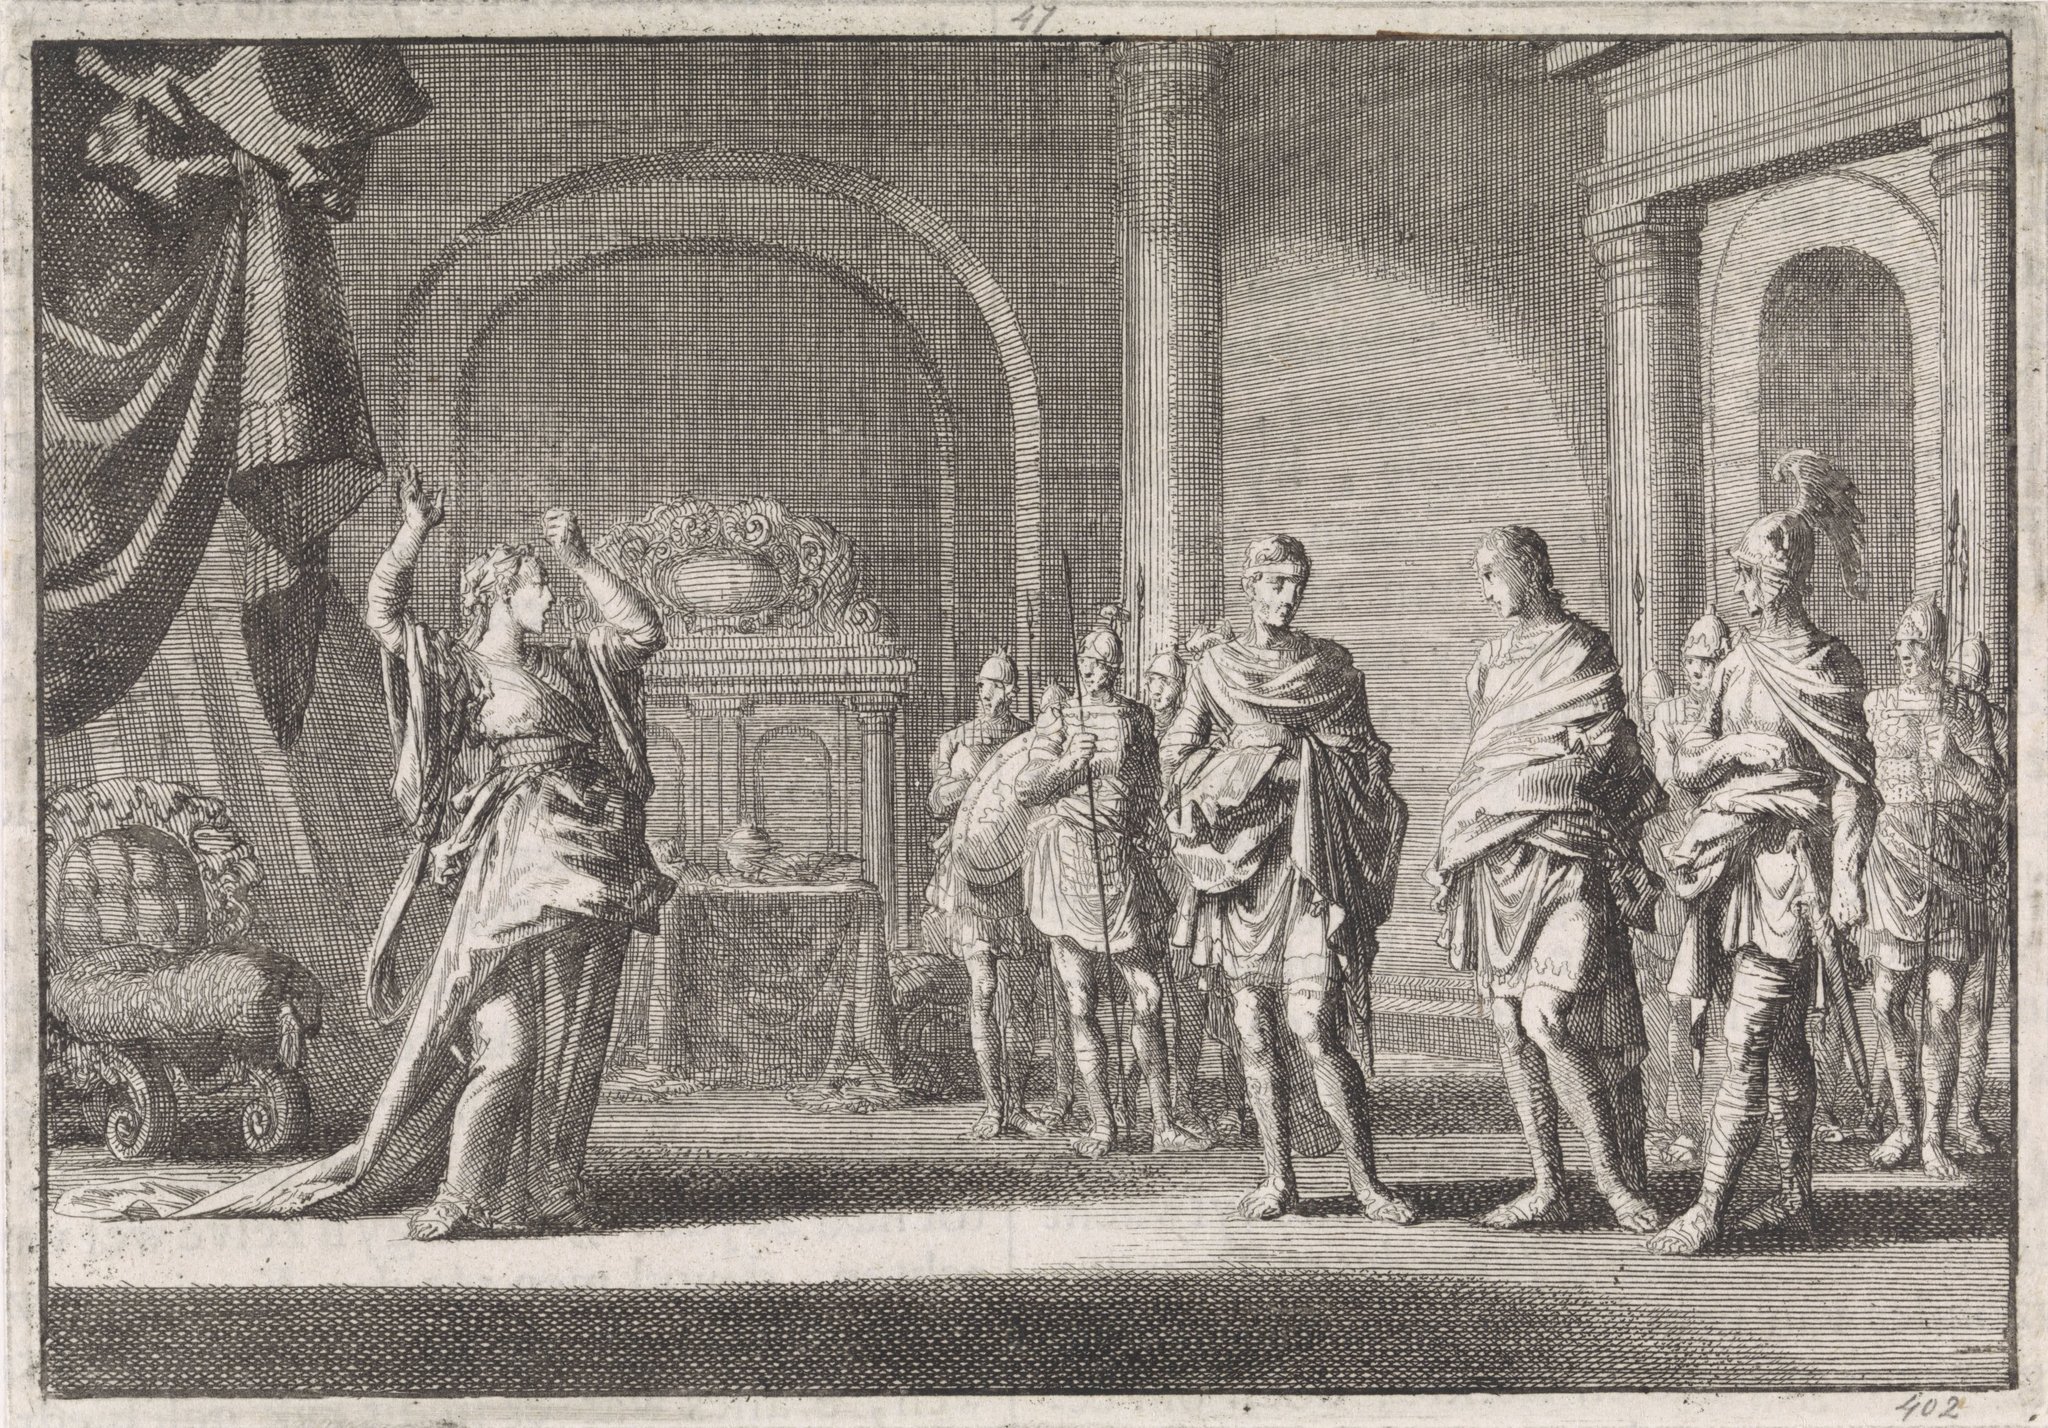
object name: print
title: Alexander, zoon van Herodes, wordt gebonden naar zijn gemalin Glasyra gebracht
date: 1704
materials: paper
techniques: etching, letterpress printing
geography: amsterdam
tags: prisoner with hands bound (+ variant)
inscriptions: collector's mark: Lugt 2228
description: Prent opgenomen in: Josephus, Flavius. Alle de Werken, 2 delen. Amsterdam: Pieter Mortier, 1704, dl. 1, p. 402.